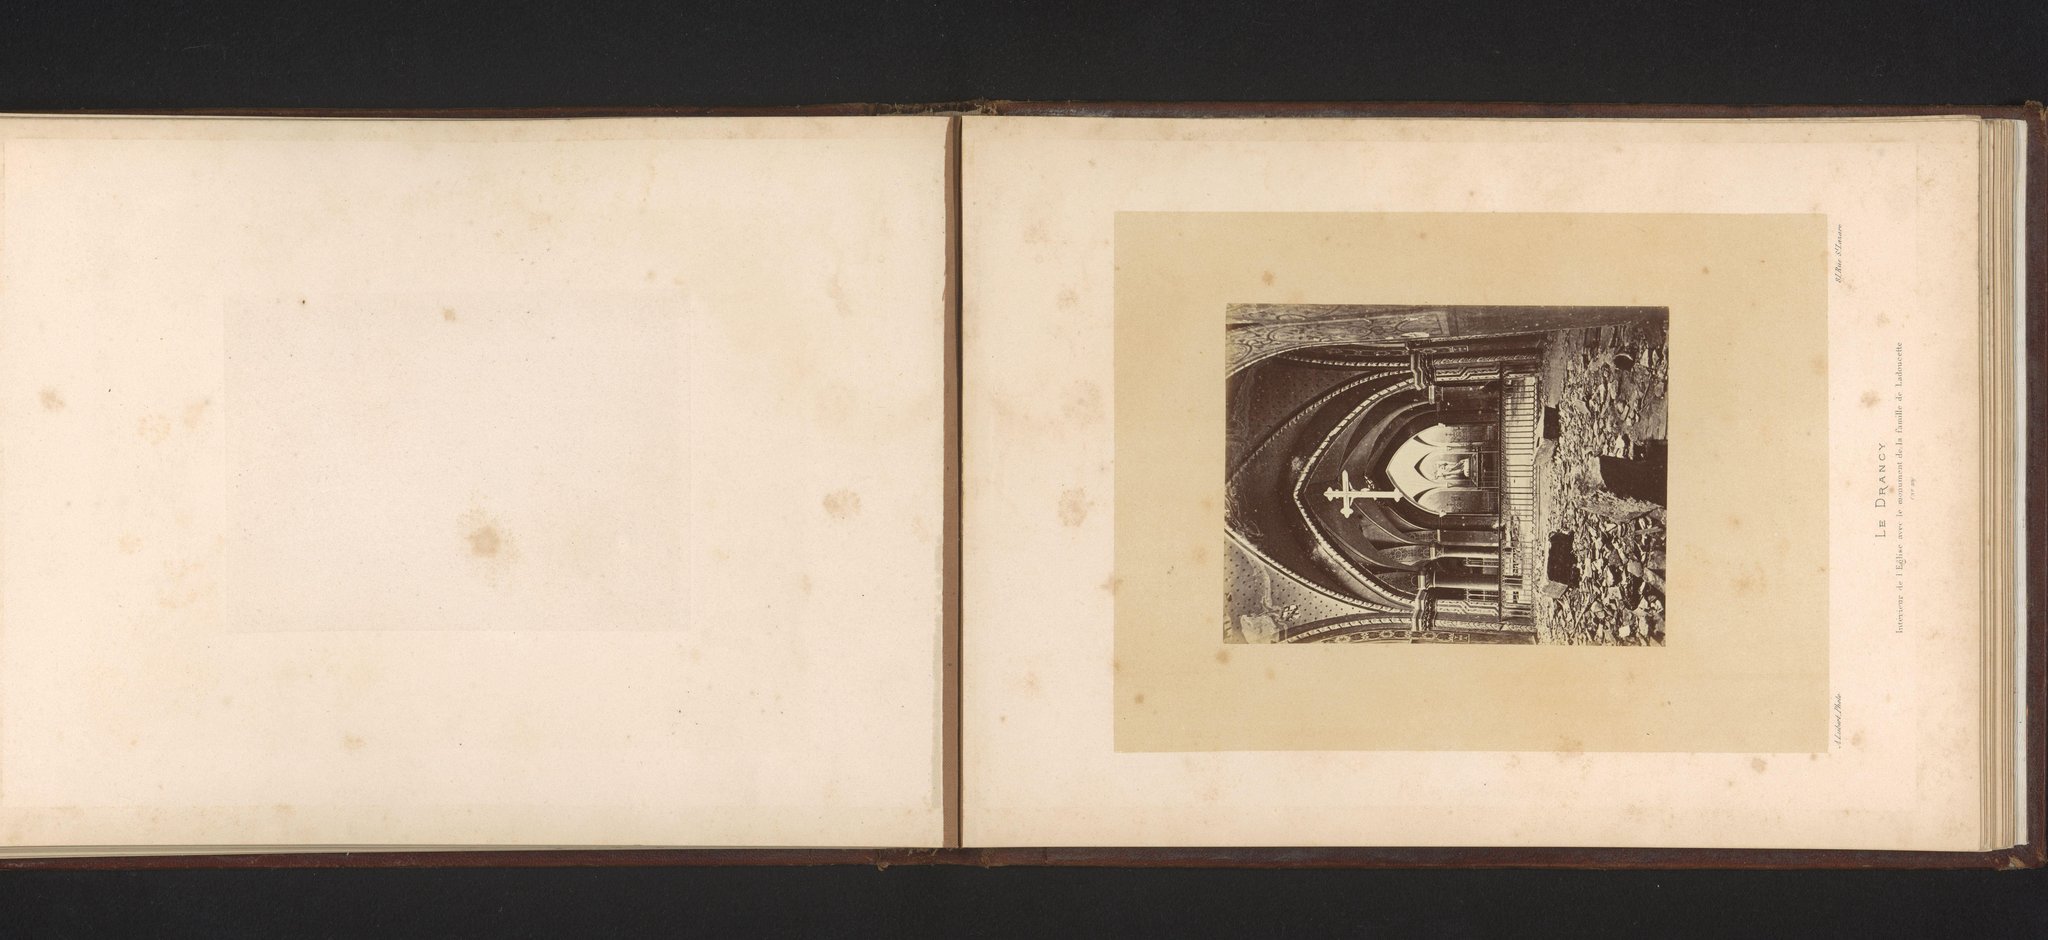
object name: page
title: Gezicht op het interieur van de kerk van Drancy met het monument voor de familie Ladoucette, na de verwoesting door de Commune van Parijs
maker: alphonse-justin liébert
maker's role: fotograaf, marinier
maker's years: 1827-1914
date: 1871-1872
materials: photographic support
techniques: albumen print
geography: drancy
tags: ruin of a building ~ architecture, parts of church interior, monument, statue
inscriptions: number: ‘(No. 89)’, address: ‘31, Rue St. Lazare’